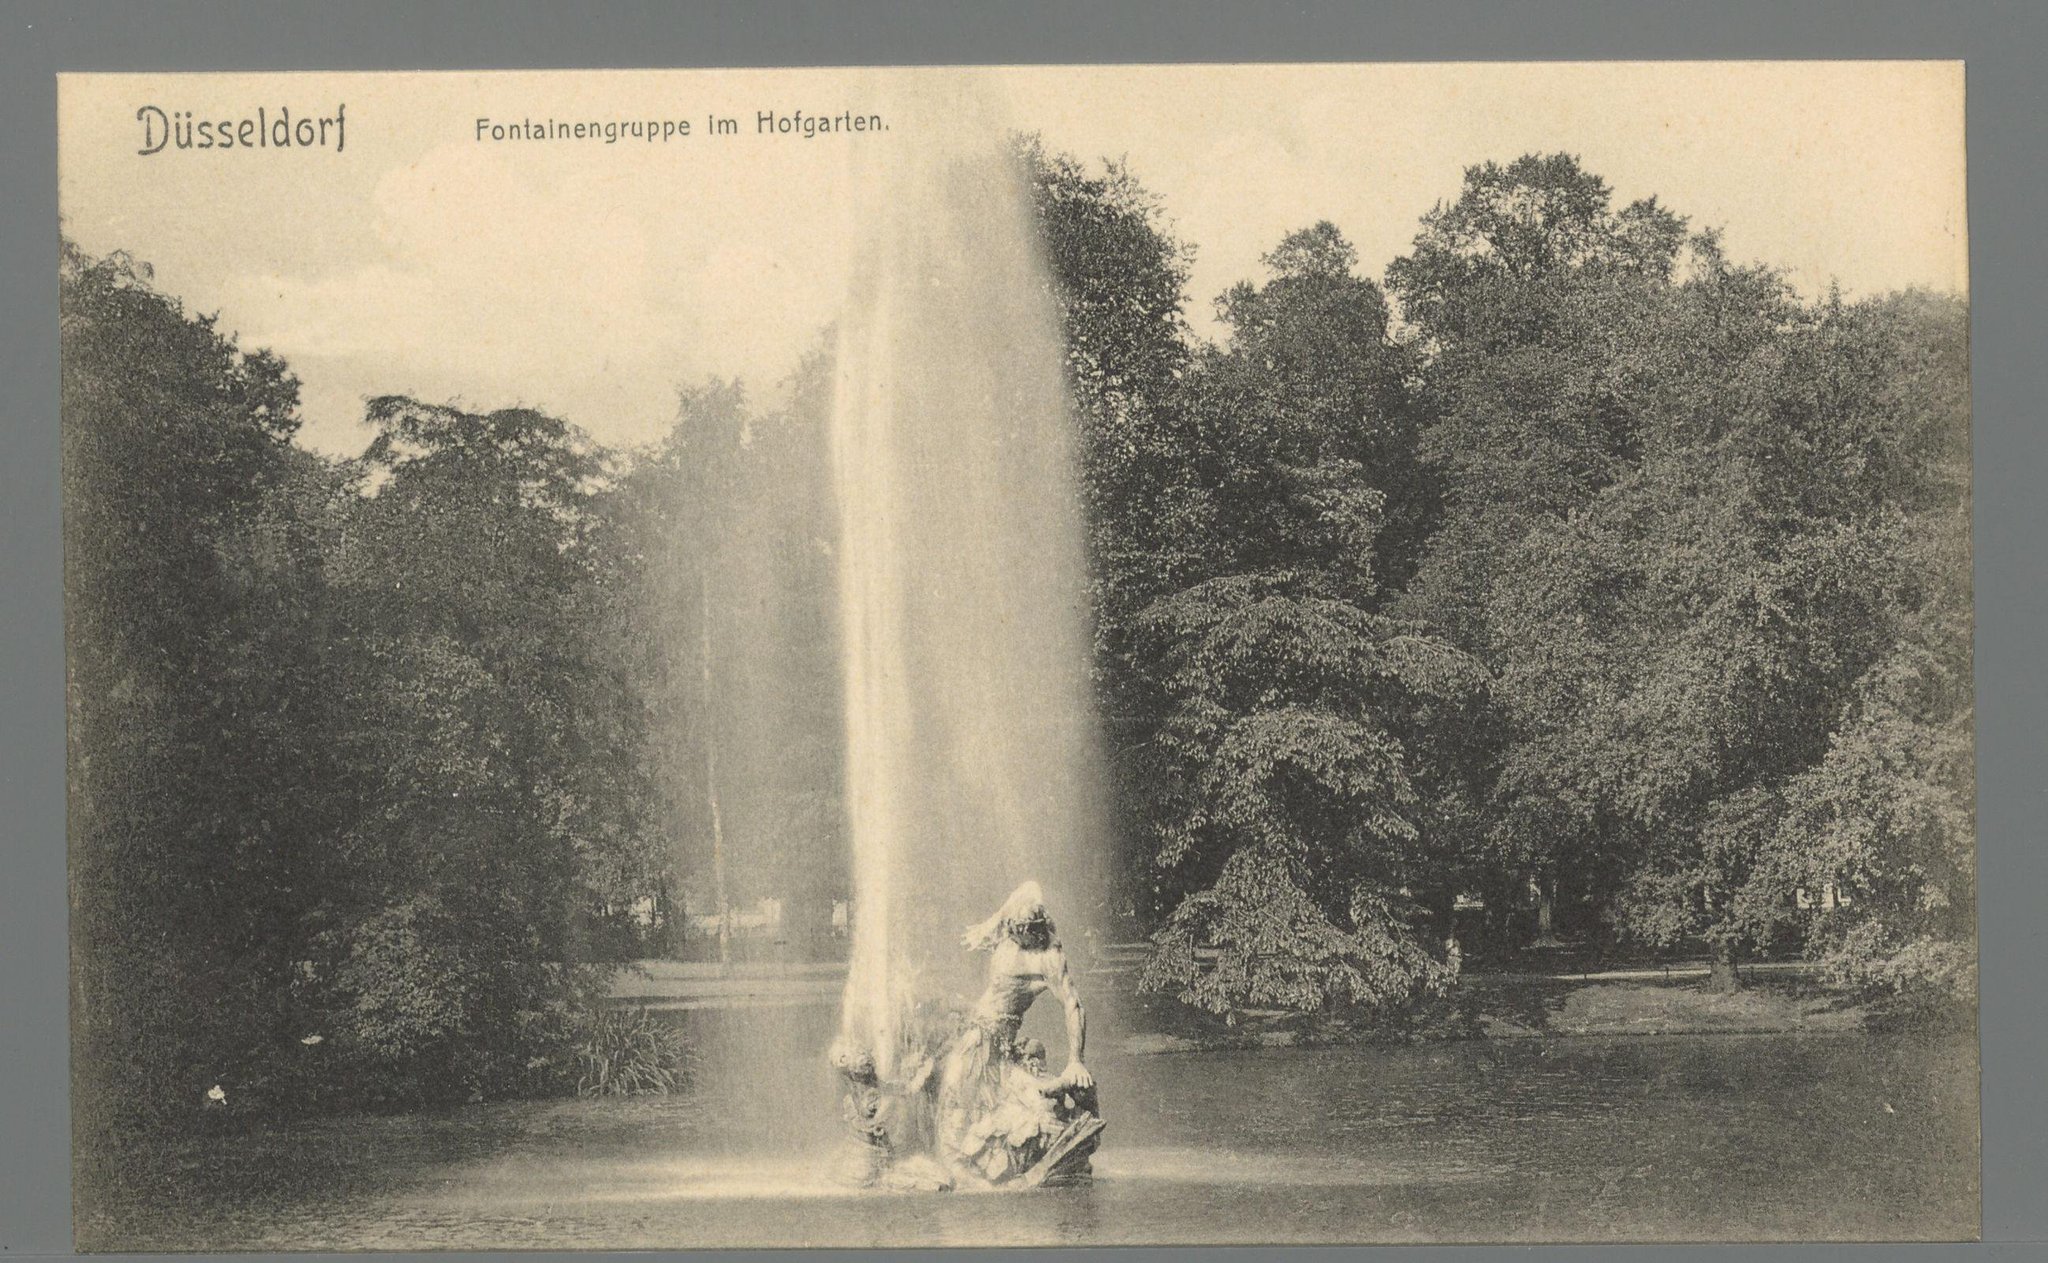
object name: ansichtkaart, prentbriefkaart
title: Düsseldorf. Fontainengruppe im Hofgarten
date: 1905-1930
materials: cardboard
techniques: photograph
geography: dusseldorf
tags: park, ornamental fountain, pond